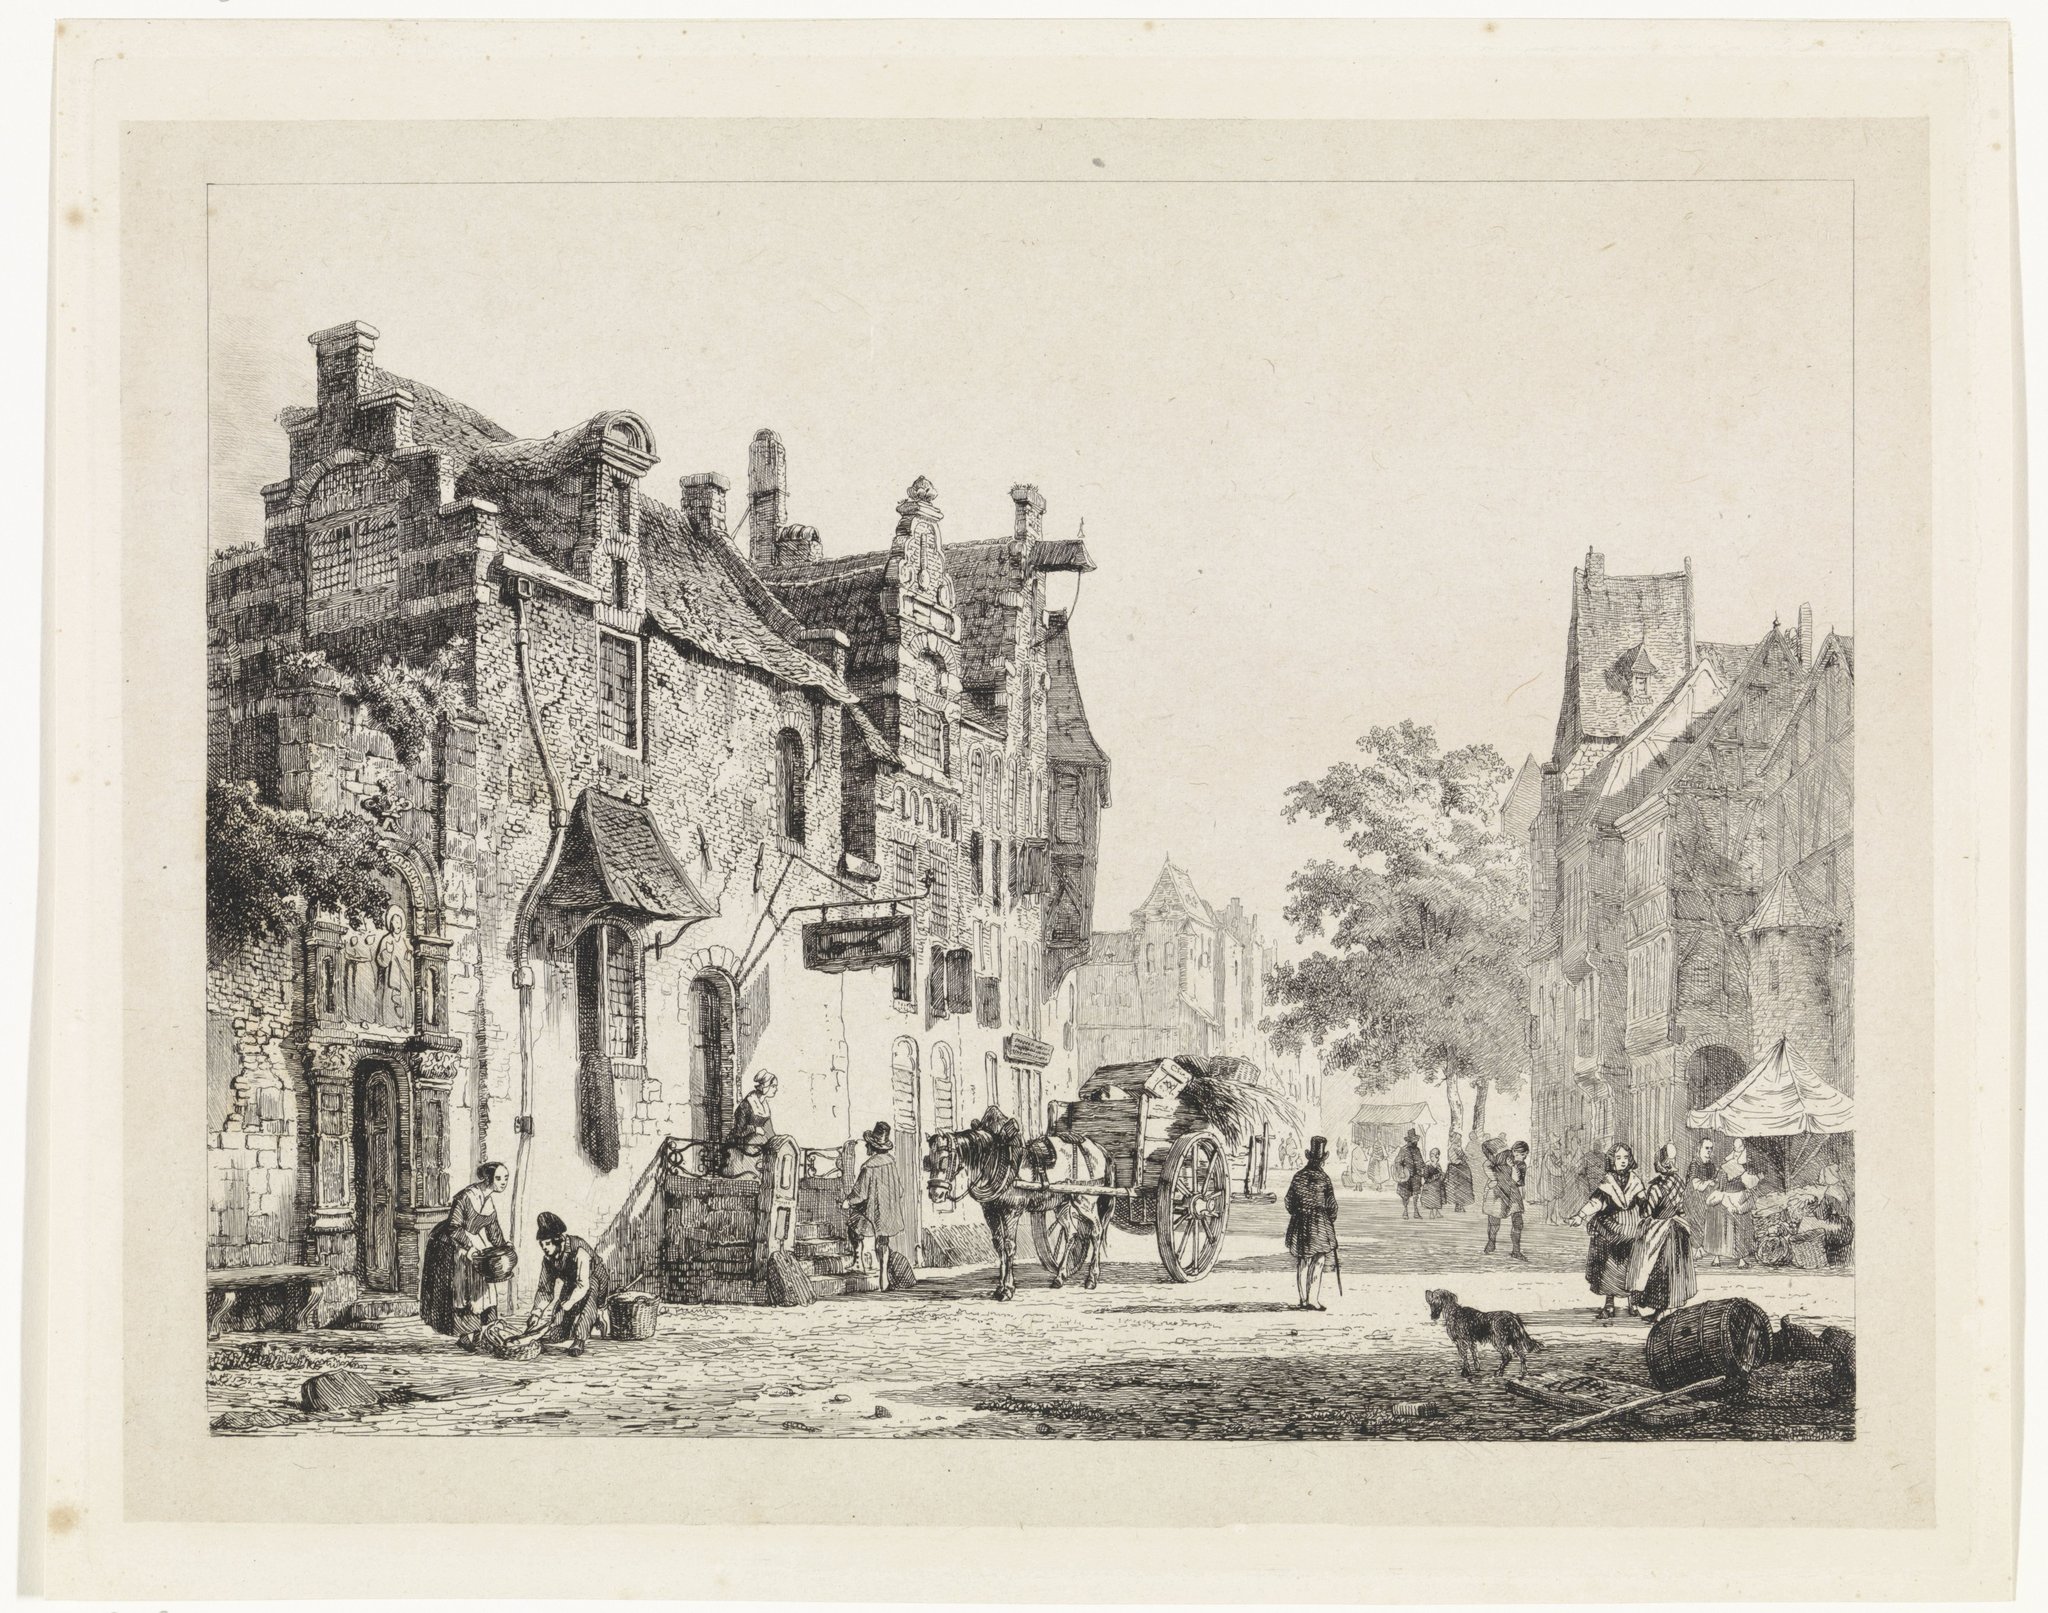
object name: print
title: Stadsgezicht met paardenkar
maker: cornelis springer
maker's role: draughtsman, painter, print maker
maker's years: 1817-1891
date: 1845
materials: paper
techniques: etching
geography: amsterdam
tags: two-wheeled vehicle drawn by one animal, village street (+ city(-scape) with figures, staffage)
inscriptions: collector's mark: Lugt 2228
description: Stadsgezicht met op straat mensen en een volgeladen paardenkar.